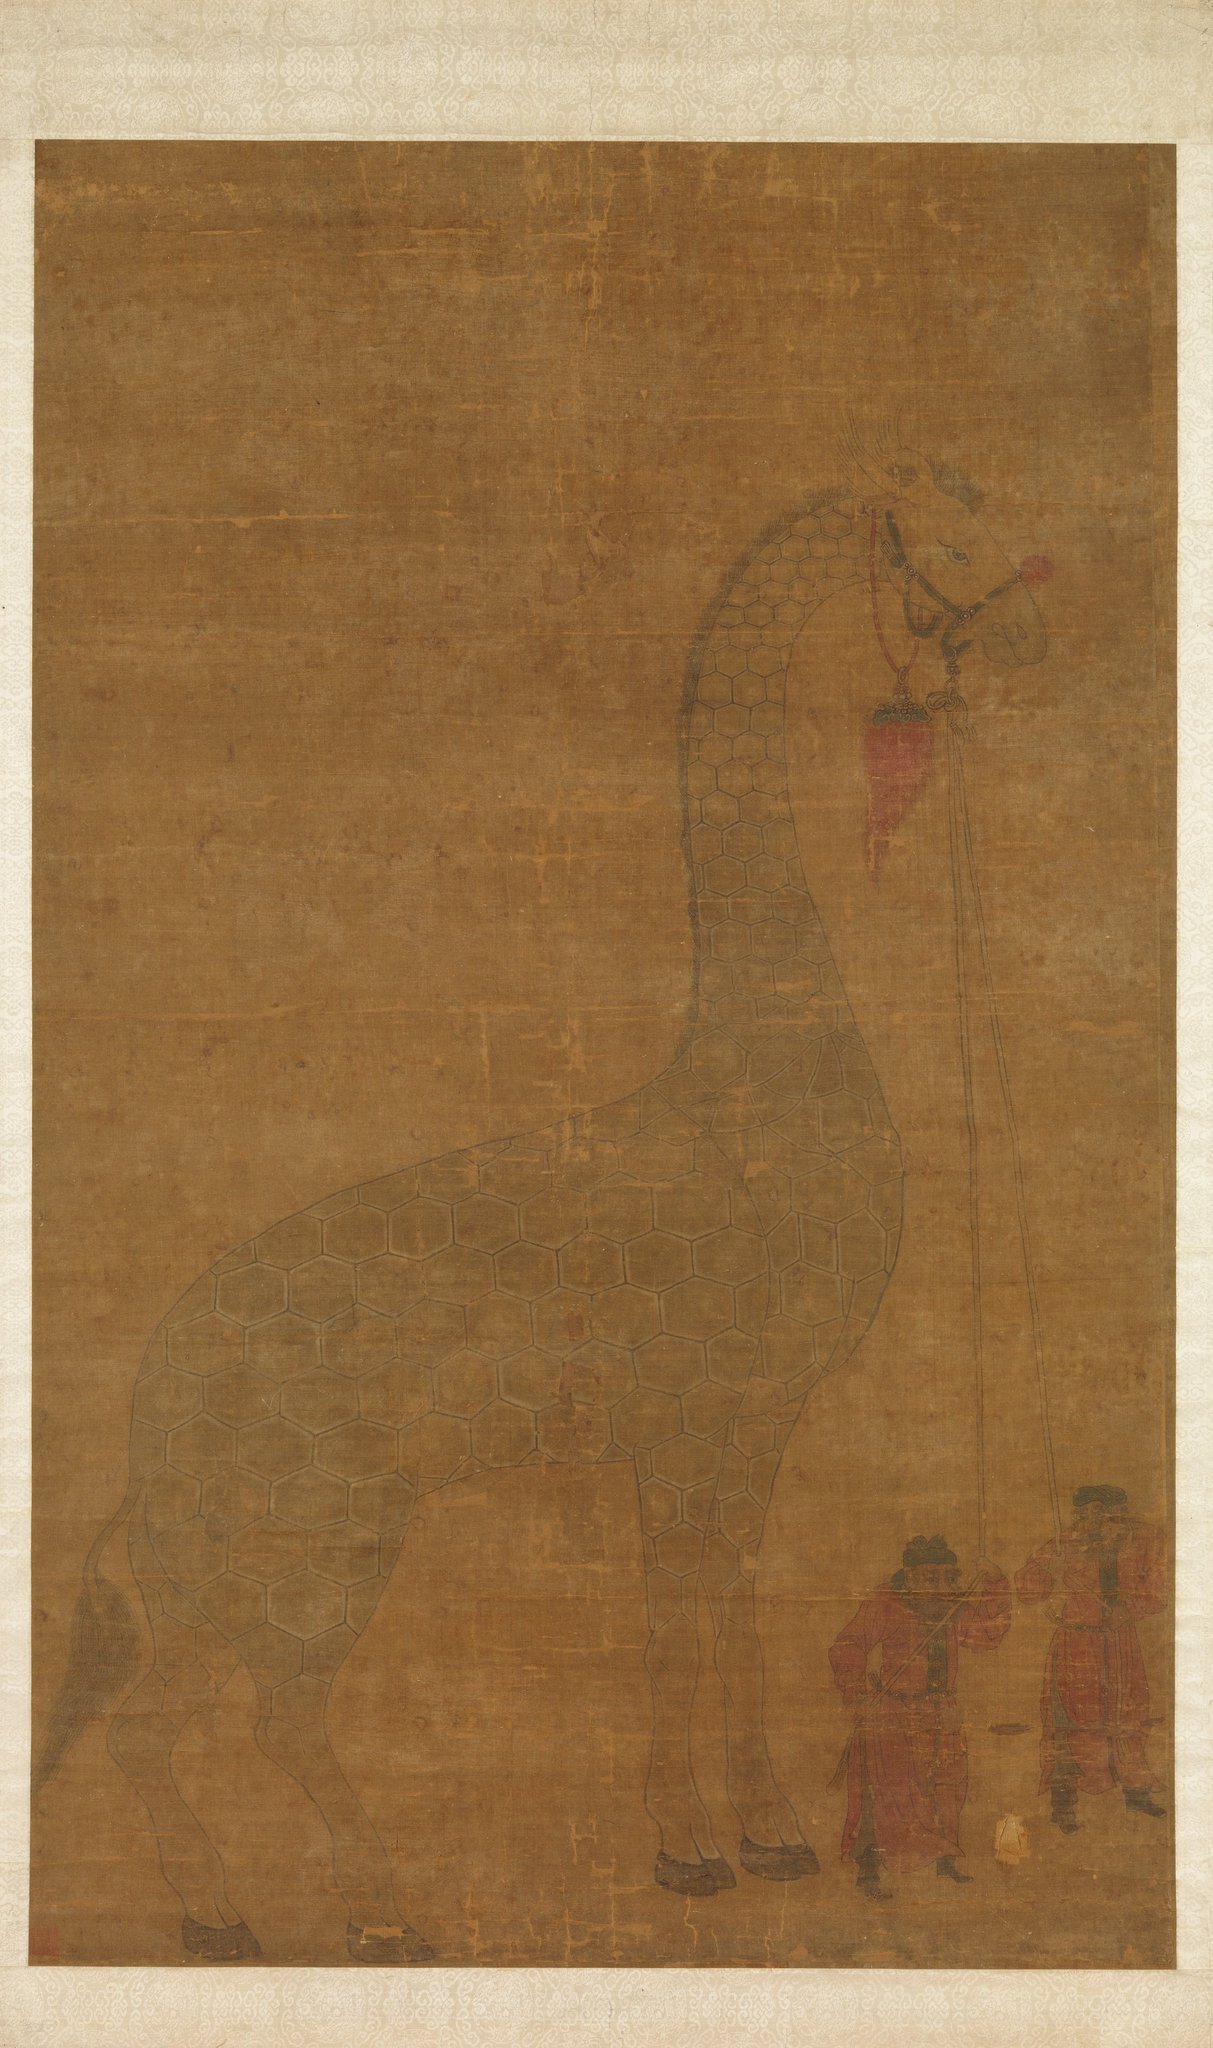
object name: painting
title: Giraffe with Two Keepers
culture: chinese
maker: unidentified artist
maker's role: artist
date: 1600-1699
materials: ink, silk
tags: men,giraffes